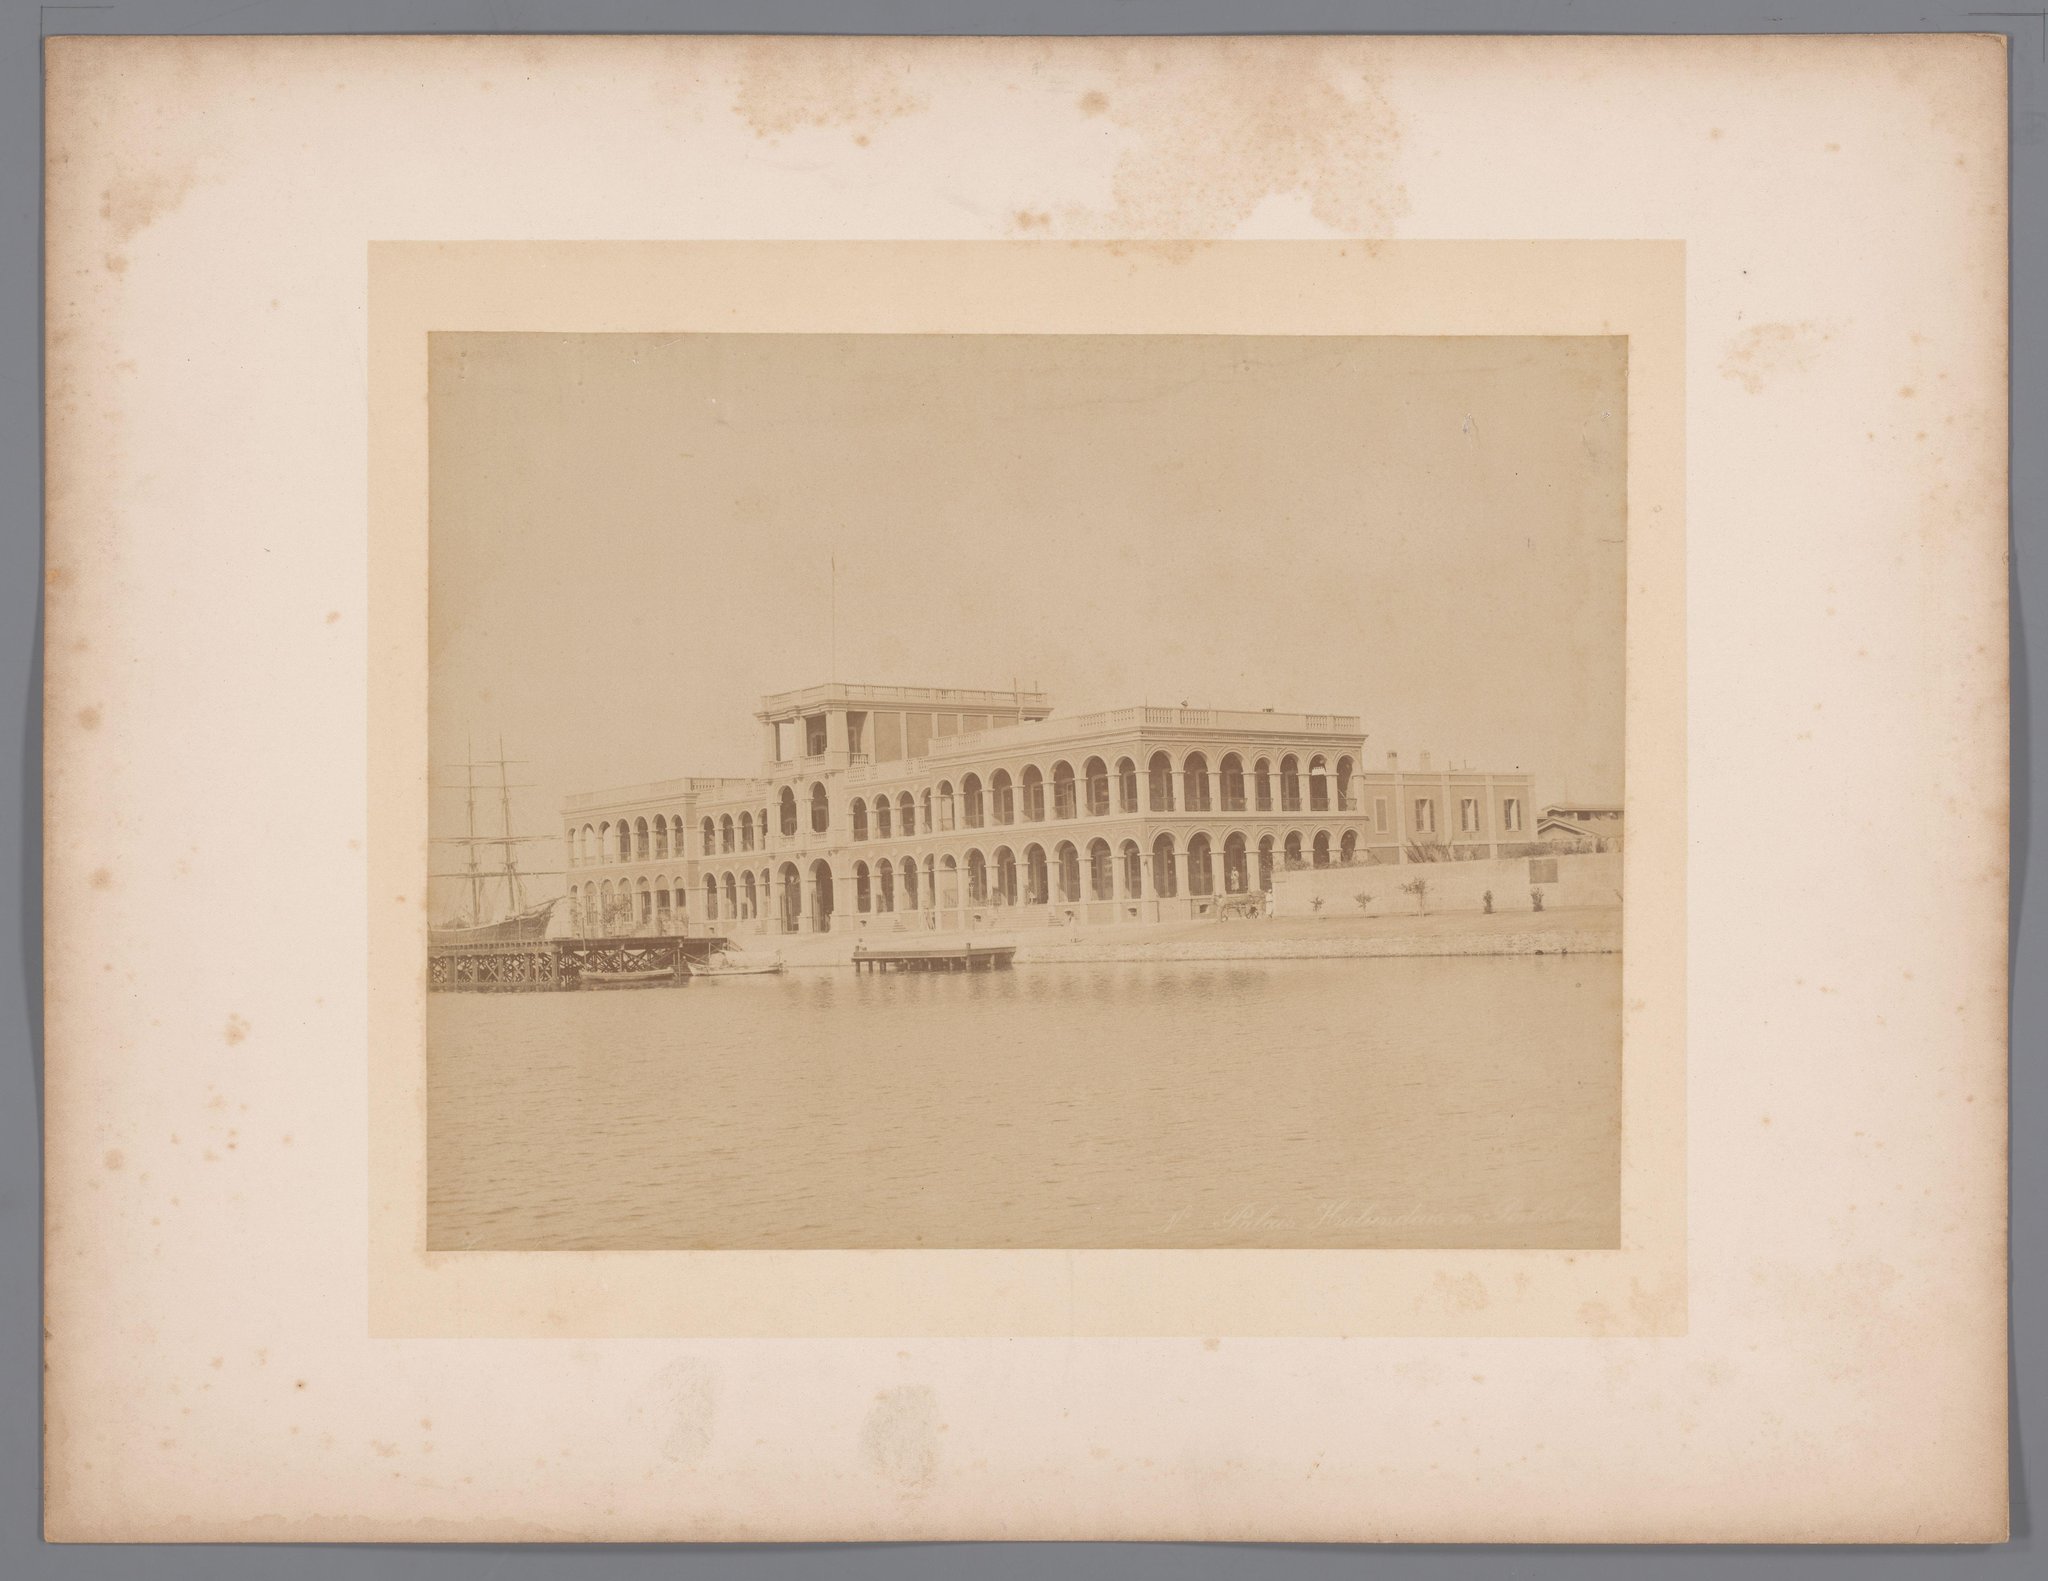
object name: photograph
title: Havenkantoor, genoemd het Palais Hollandais, te Port Said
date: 1870-1910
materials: cardboard, paper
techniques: albumen print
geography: port said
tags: harbour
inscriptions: inscription: ‘Port Said’